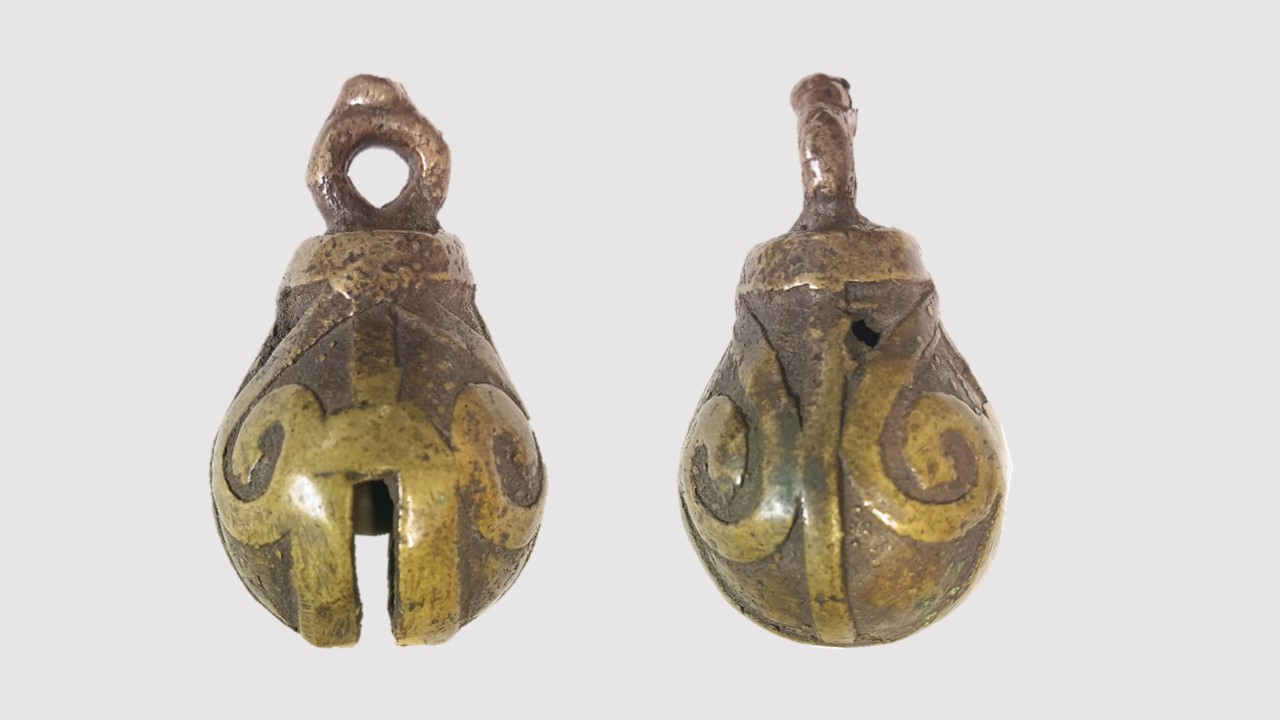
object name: garonong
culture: bornean or dyak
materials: brass, bronze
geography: malaysia